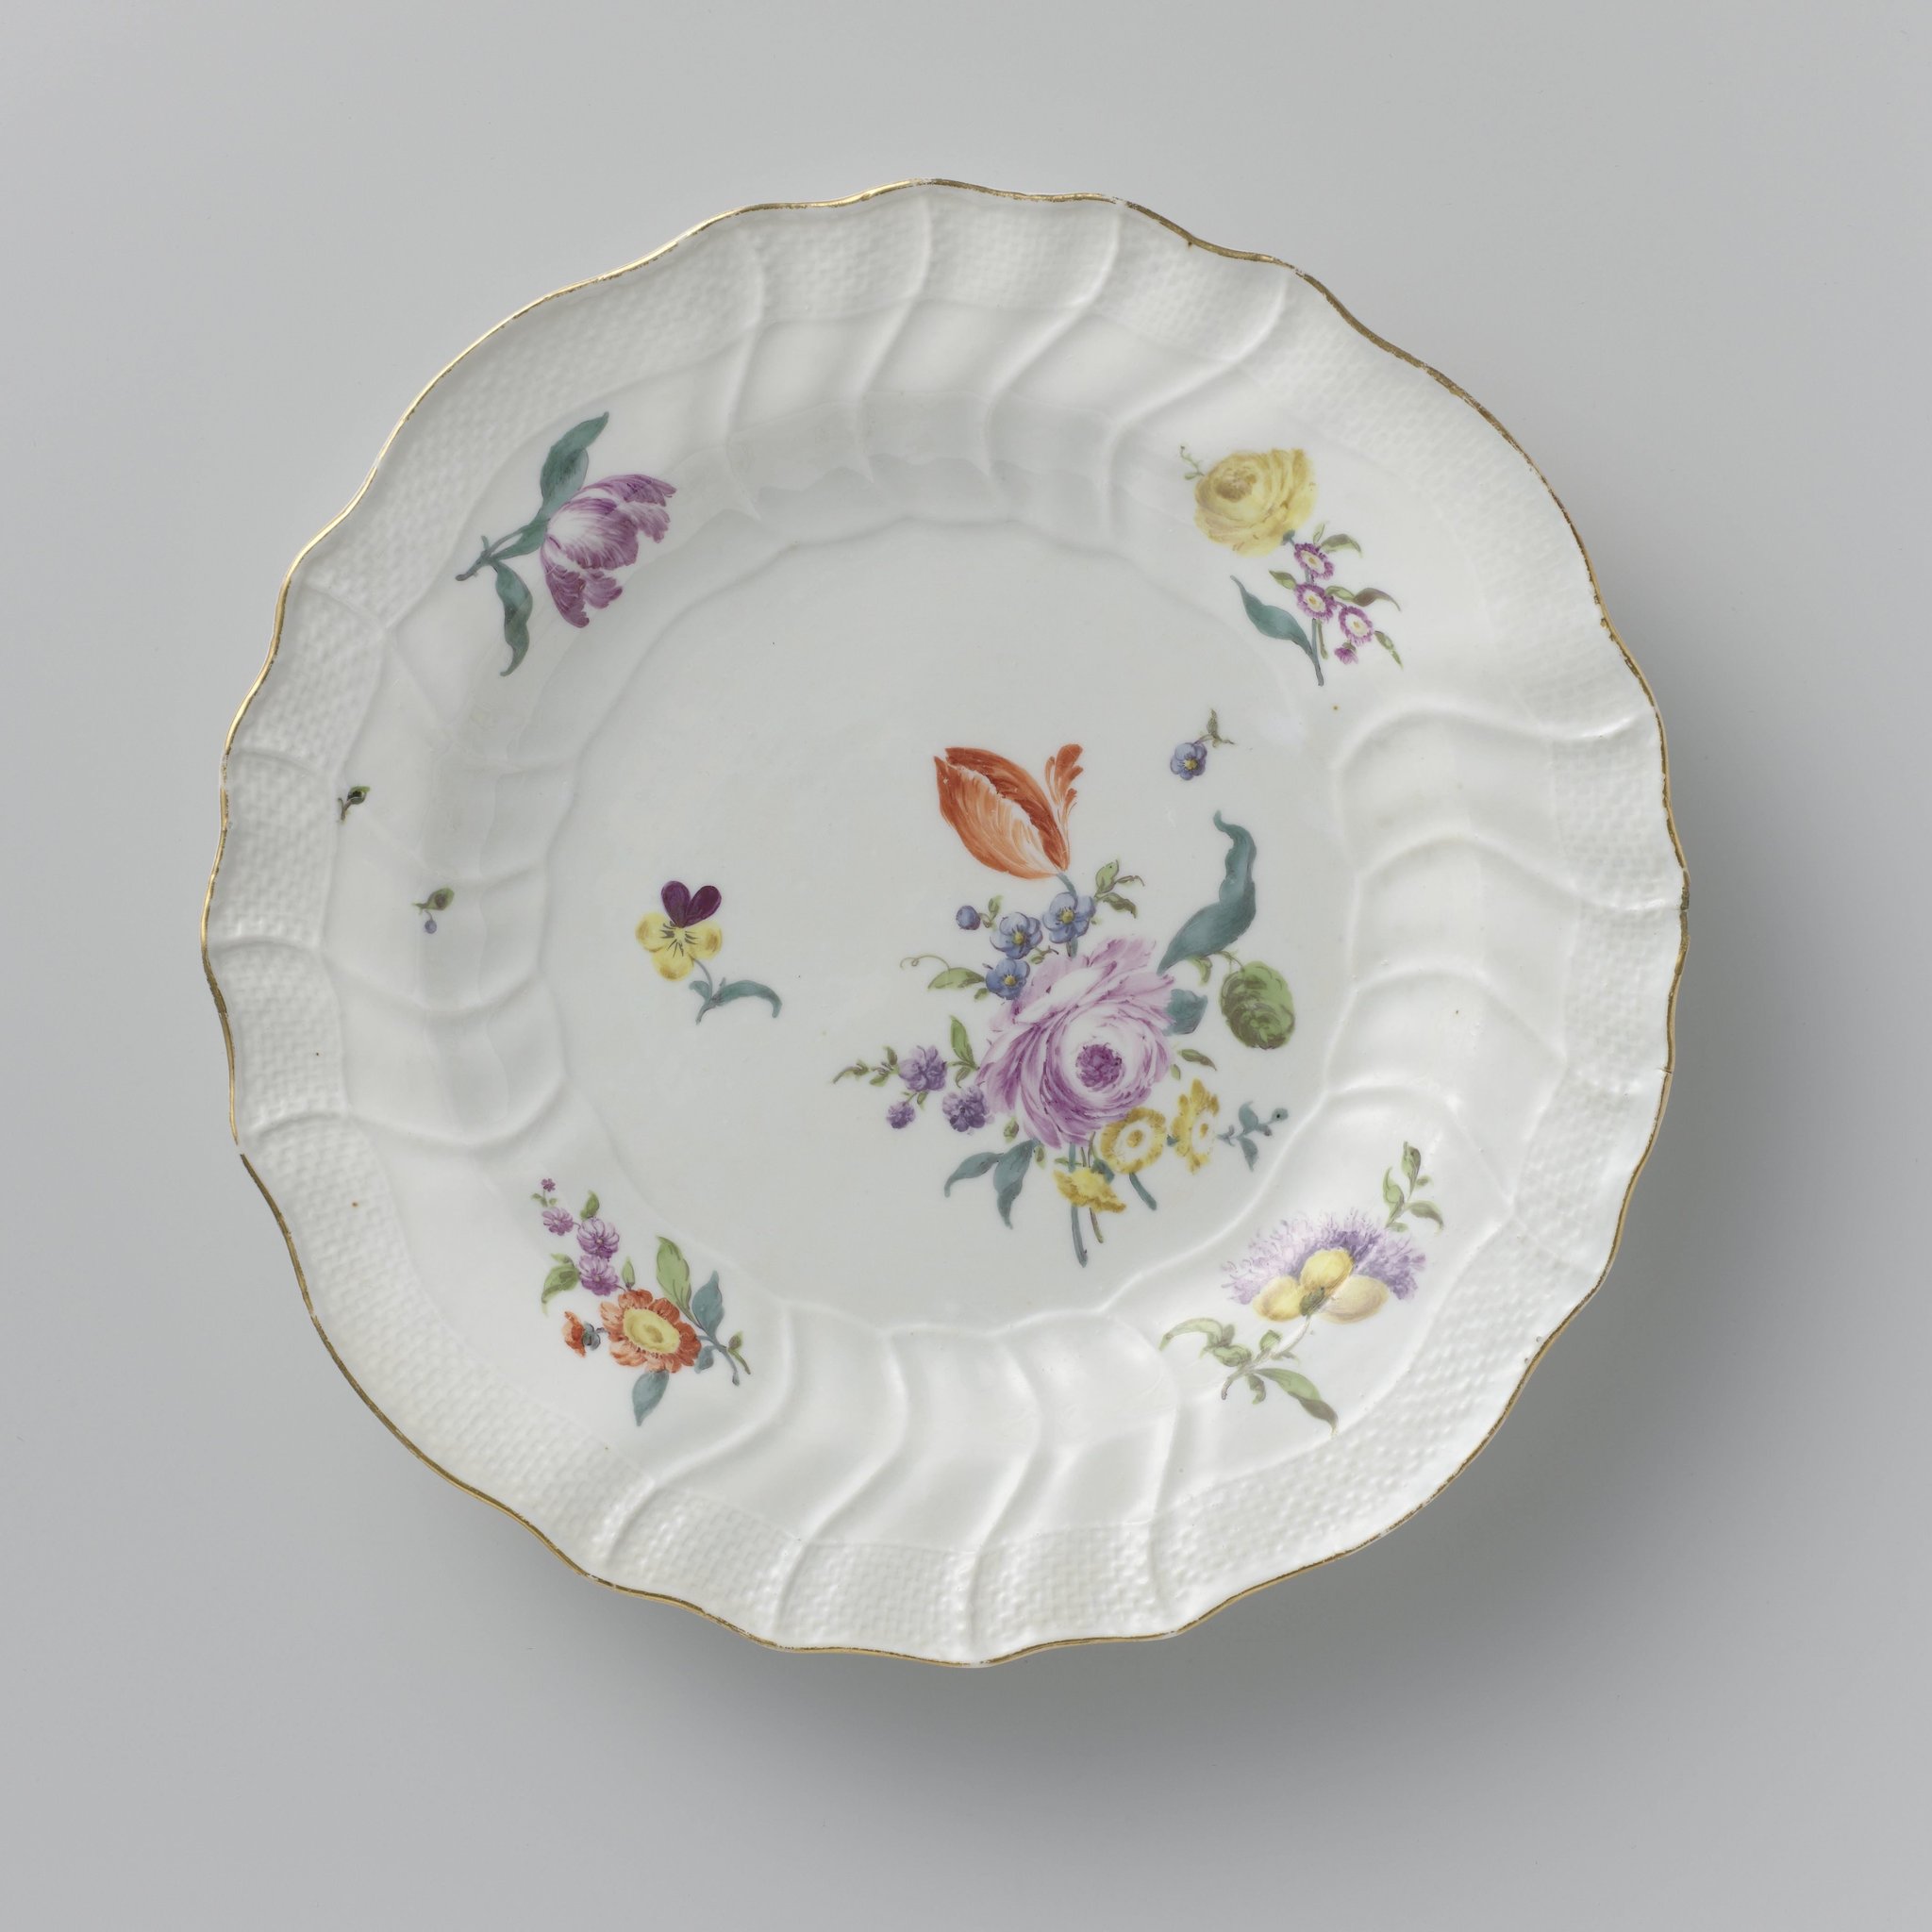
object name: eating drinking utensil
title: Bord, veelkleurig beschilderd met Deutsche Blumen, insekten en vruchten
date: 1750-1760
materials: porcelain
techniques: painted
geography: meissen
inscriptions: factory mark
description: Rond bord van beschilderd porselein. Het bord is beschilderd met Deutsche Blumen, insekten en vruchten. De rand is in reliëf versierd met het Neuozier-patroon. Het bord is gemerkt en hoort bij een servies (BK-17474-1 t/m BK-17474-253).